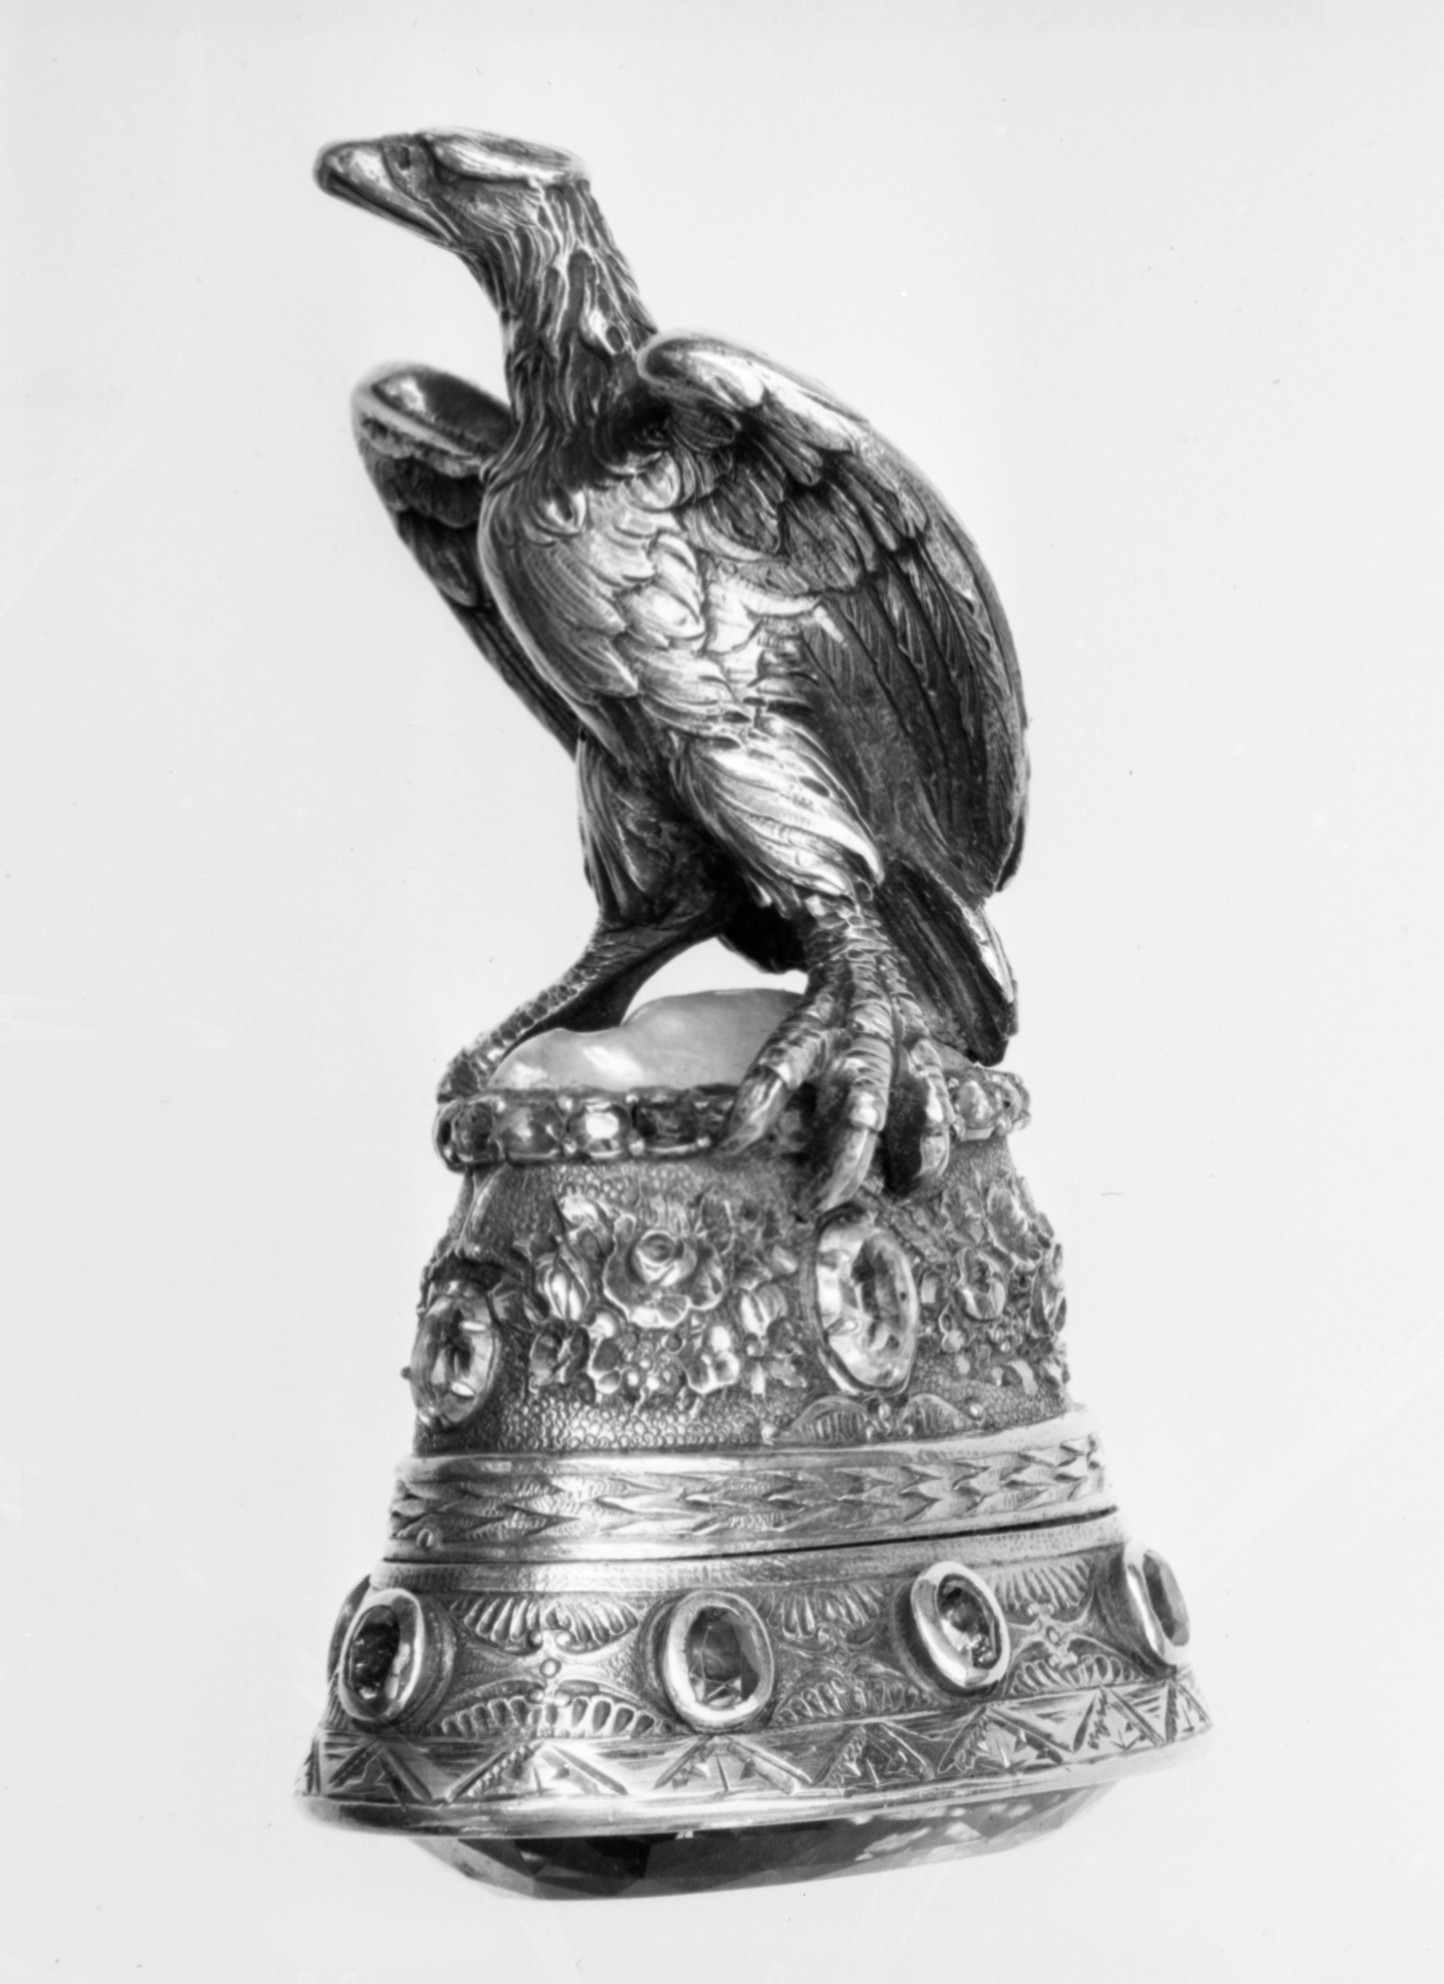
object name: seal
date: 1801-1900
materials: silver, stone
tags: birds